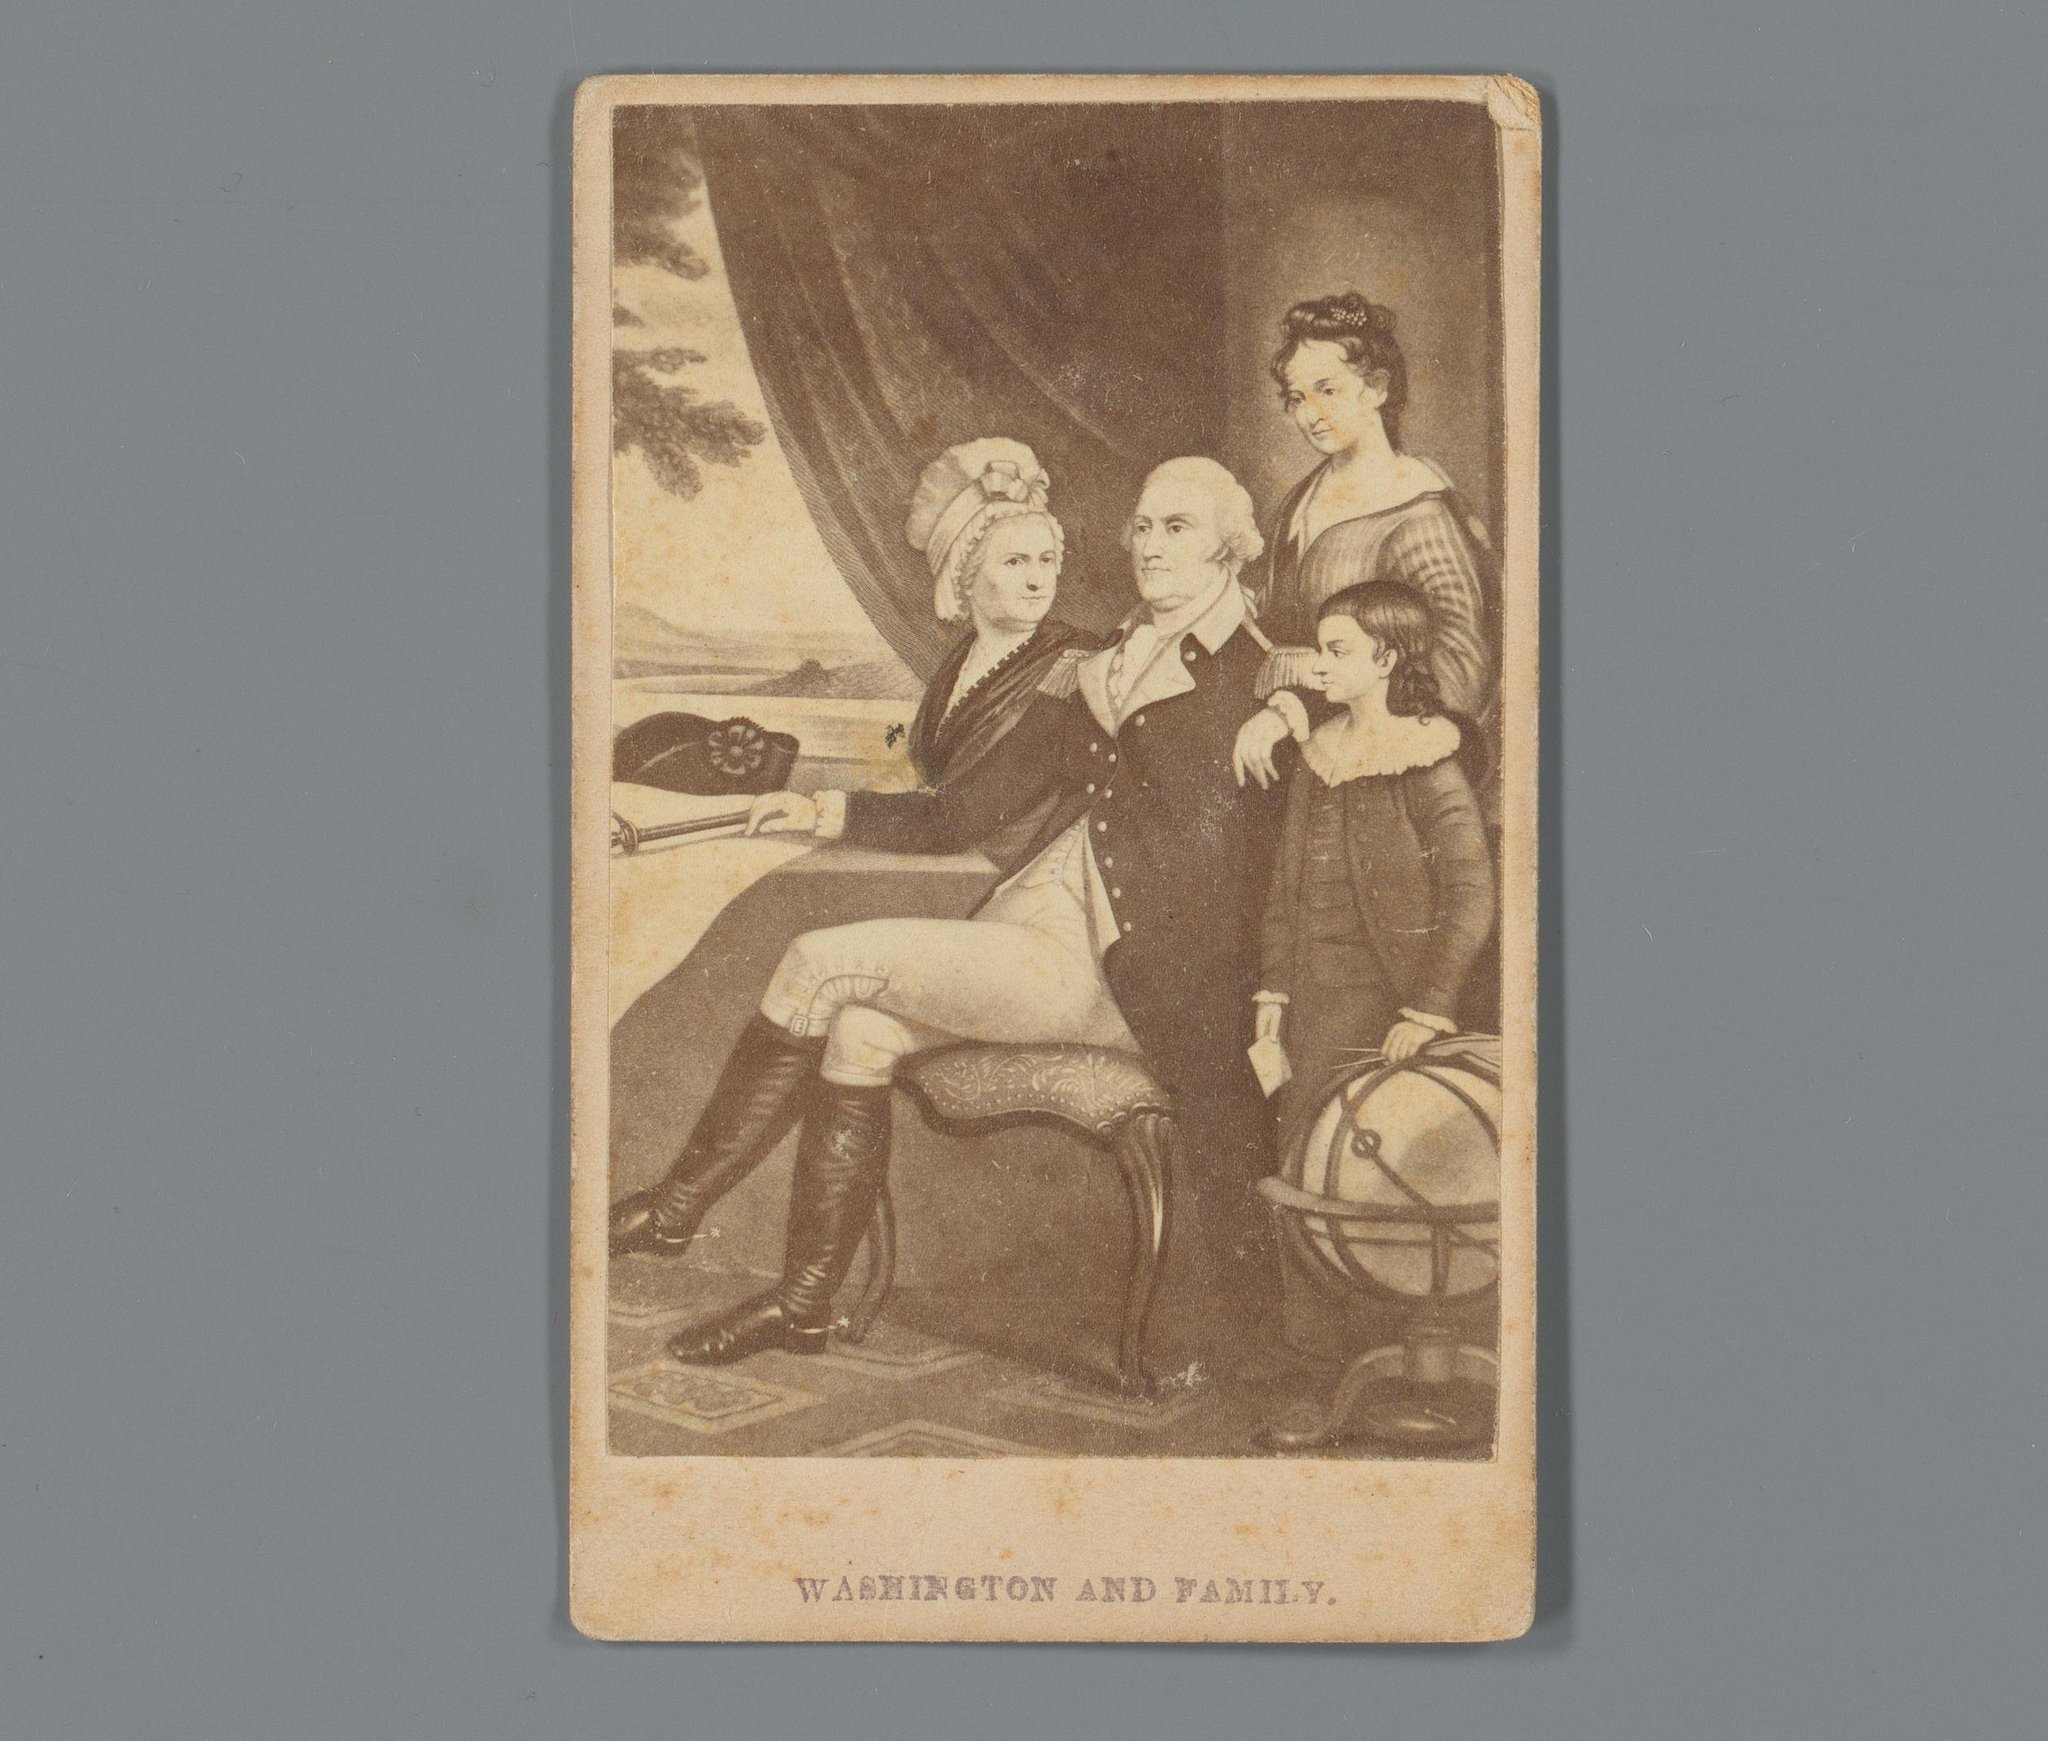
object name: photograph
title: Washington and family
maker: Anonymous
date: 1850-1915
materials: cardboard, photographic support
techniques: albumen print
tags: advertising, historical persons - bb - woman, president ~ head of republic, historical persons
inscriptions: inscription: ‘ABBOTT'S, / CHEAP STORE! (...) 28 Essex Street.’